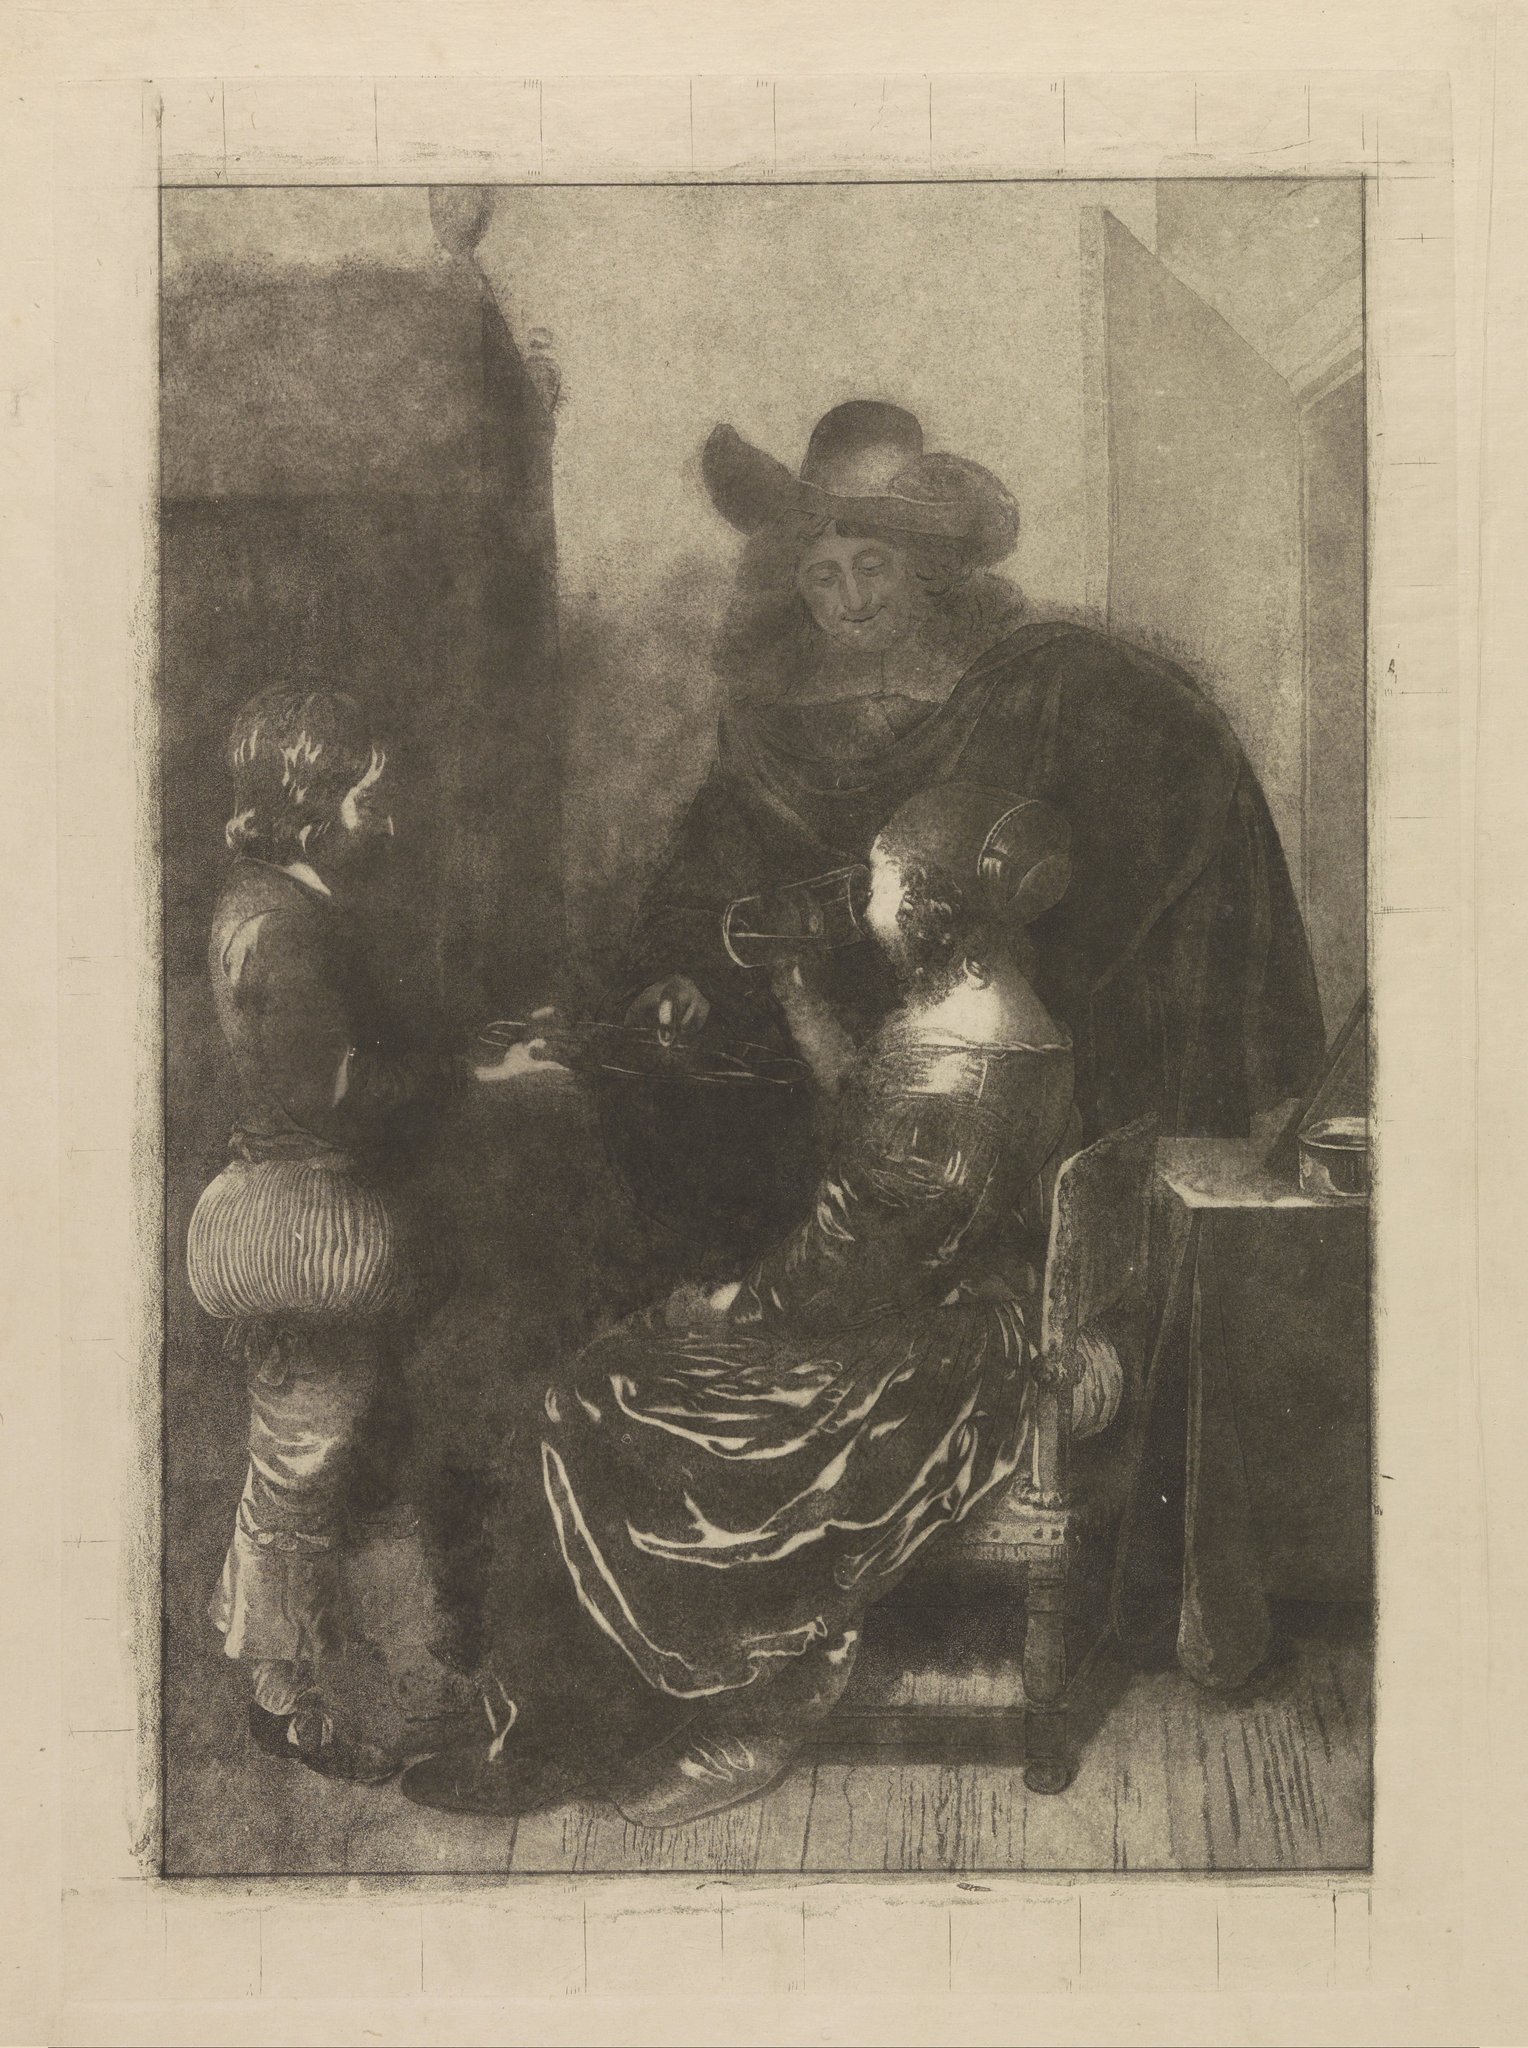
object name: print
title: Heer en dame met page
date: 1779-1781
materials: paper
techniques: etching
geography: amsterdam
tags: serving-dish, platter, glass, rummer, house personnel, servants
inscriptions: collector's mark: Lugt 2228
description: Een page presenteert een dienblad aan een dame en een heer. De vrouw drinkt uit een glas.